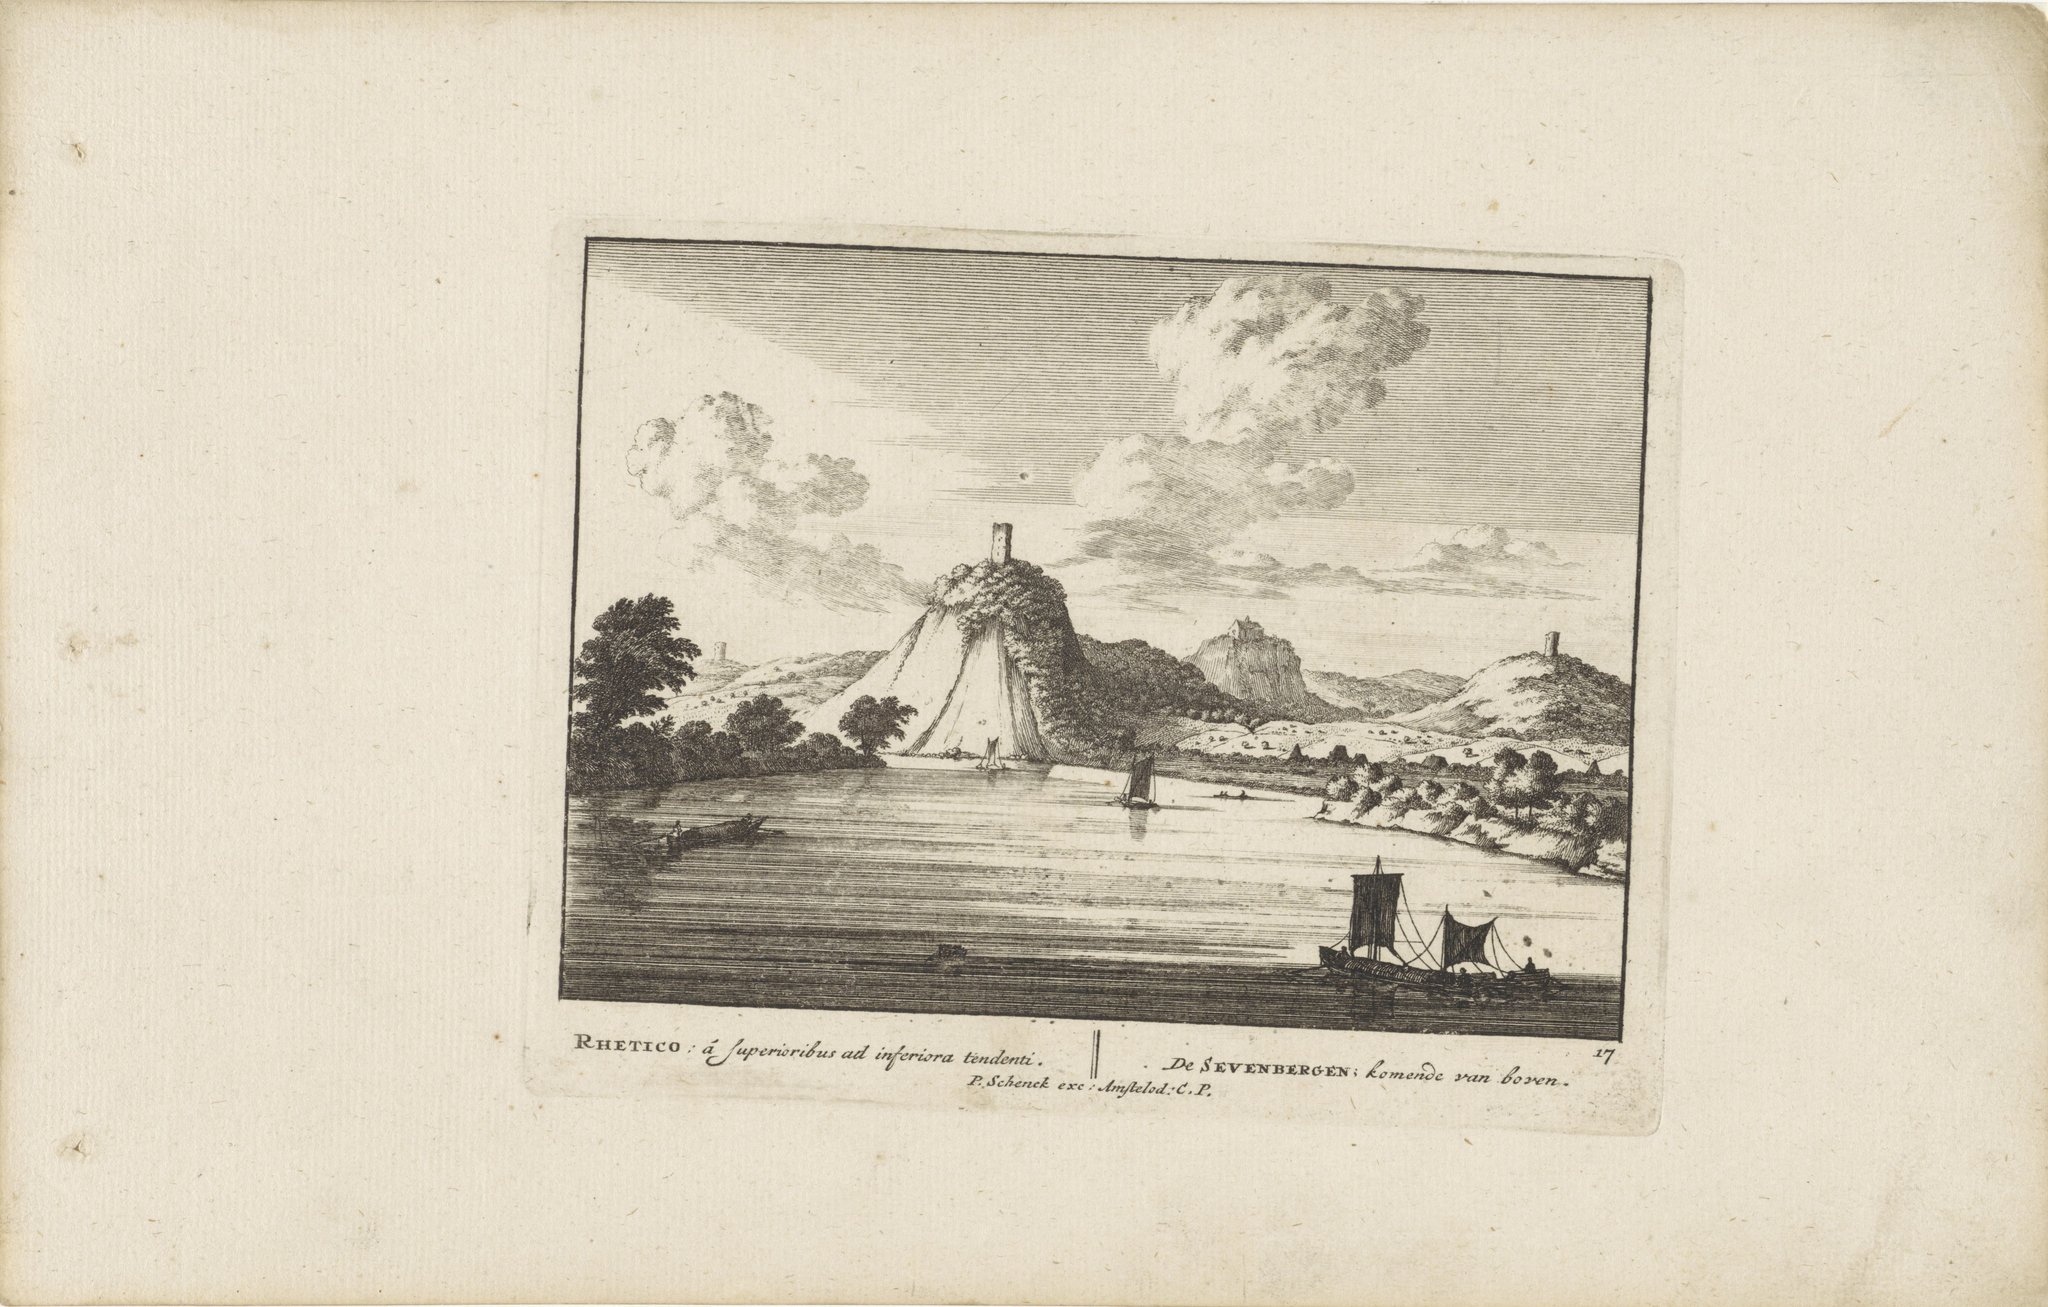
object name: print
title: Admirandorum quadruplex spectaculum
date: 1694-1697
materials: paper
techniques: etching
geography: amsterdam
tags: river, mountains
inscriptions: collector's mark: Lugt 2228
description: Gezicht op het Zevengebergte en de Rijn. Prent uit een serie van 71 prenten met Rijnlandschappen, gezichten op vorstelijke paleizen en stadsgezichten uit Den Haag en Amsterdam.